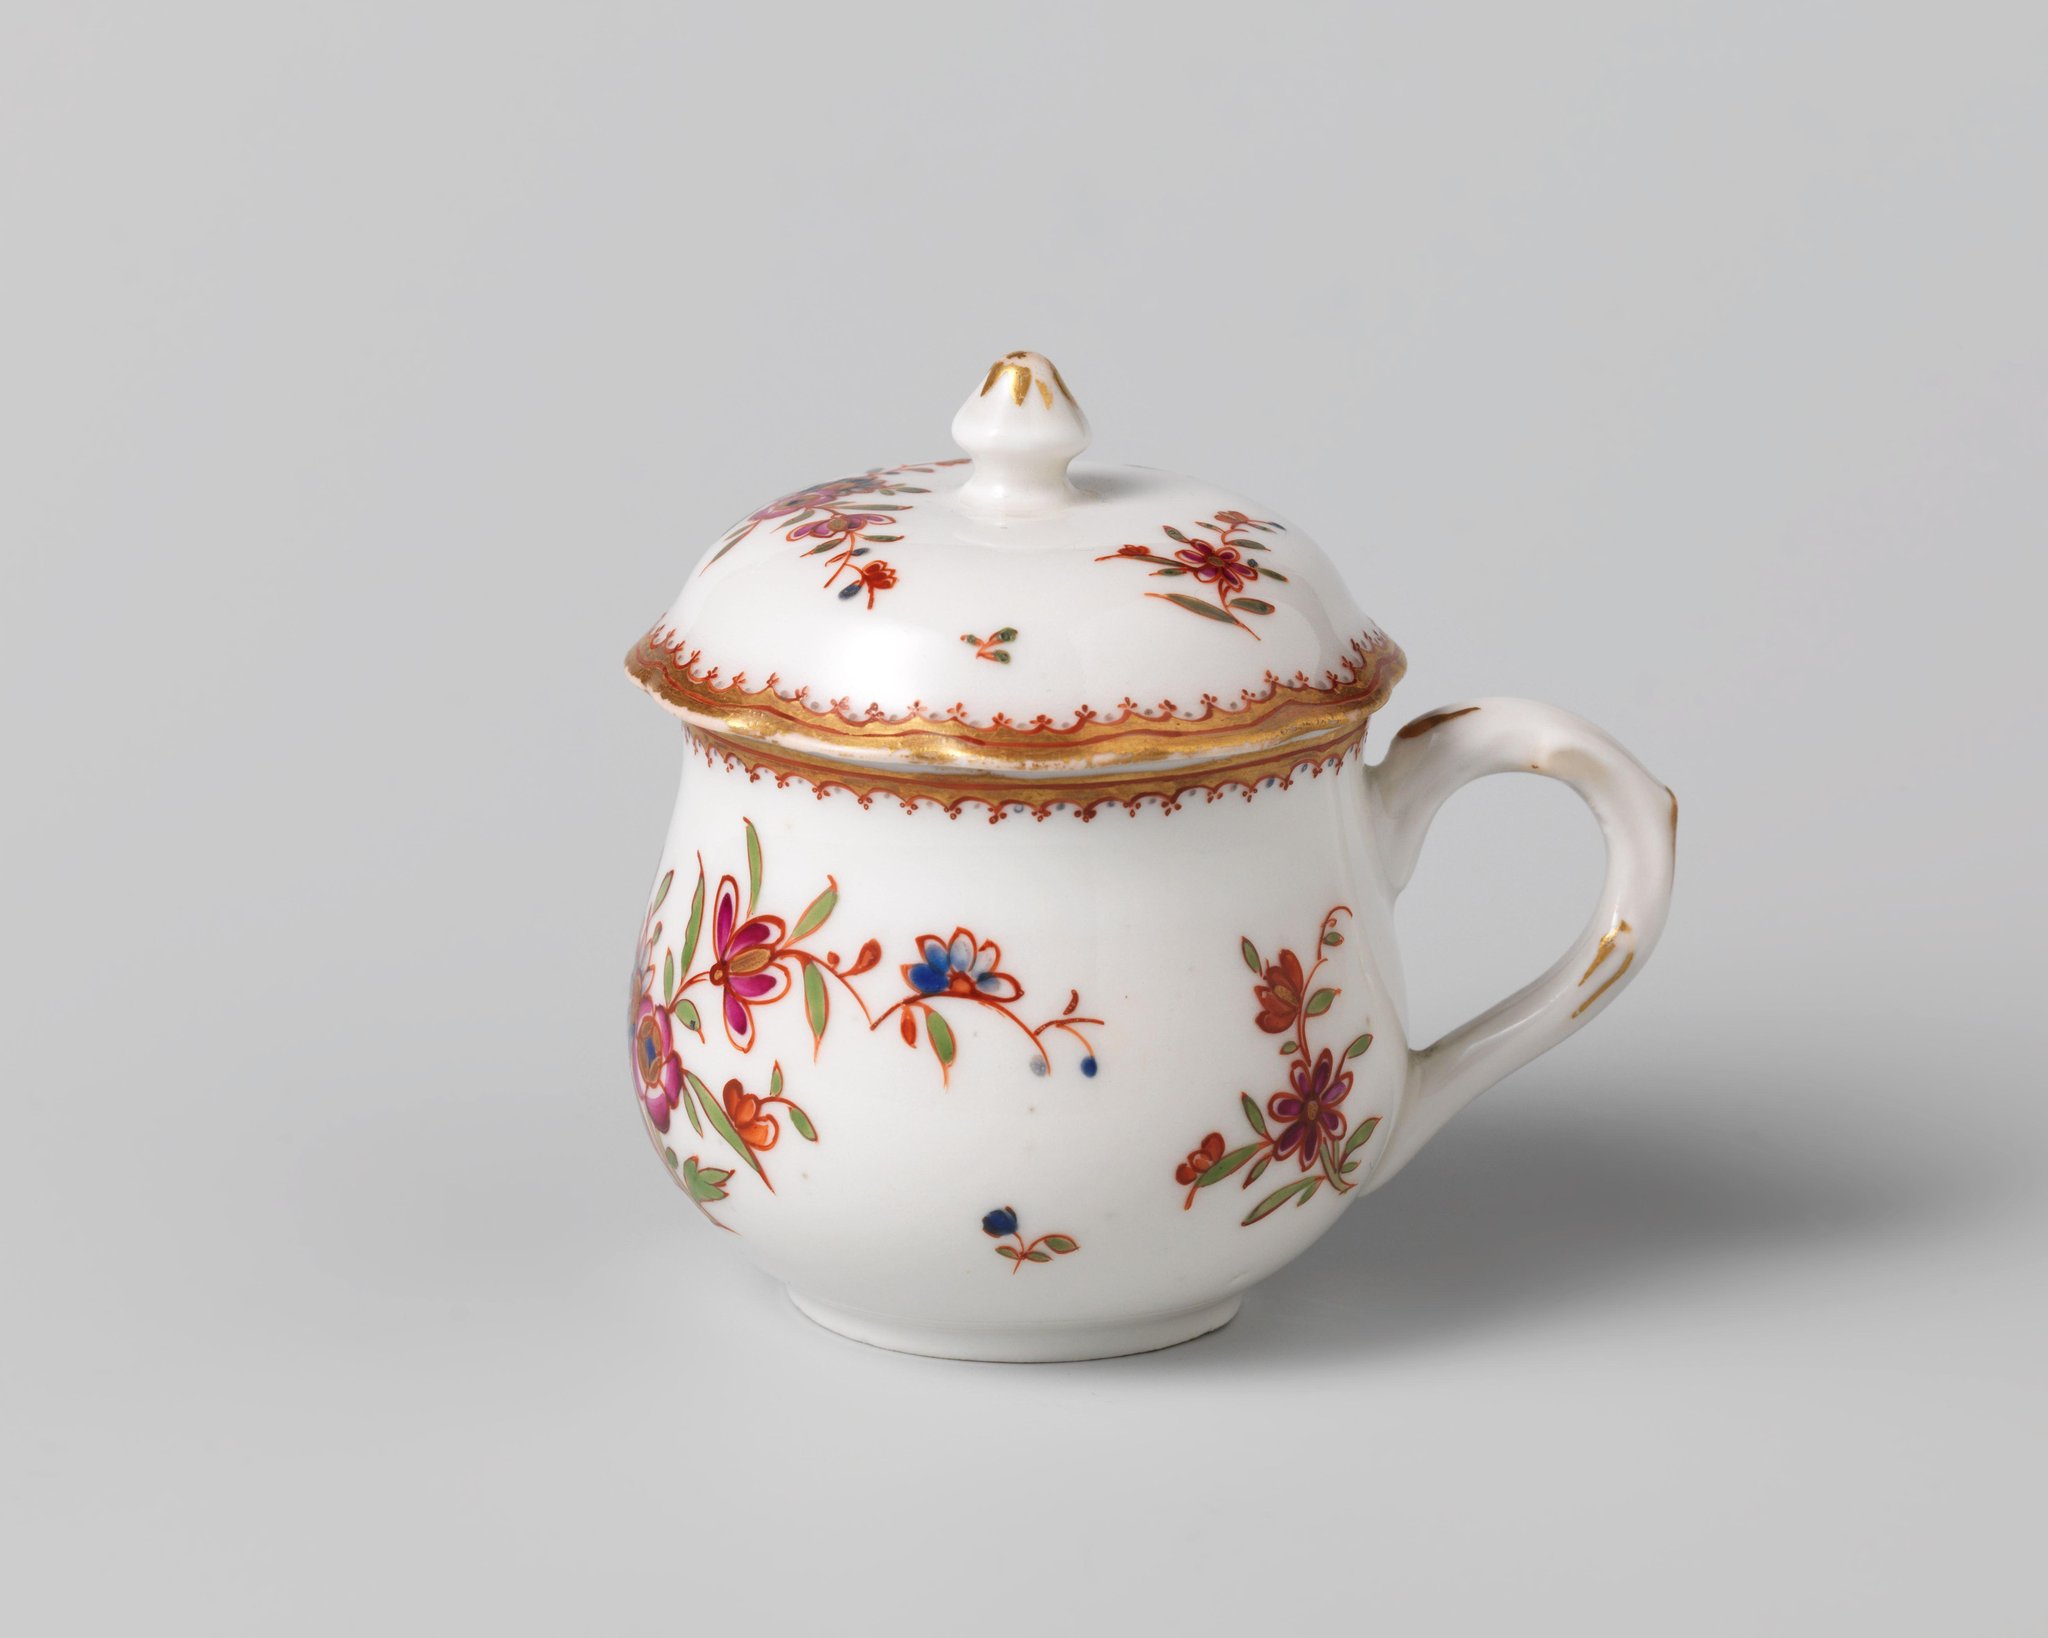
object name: crèmepot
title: Deksel beschilderd met 'Indianische Blumen'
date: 1778-1782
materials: porcelain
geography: loosdrecht